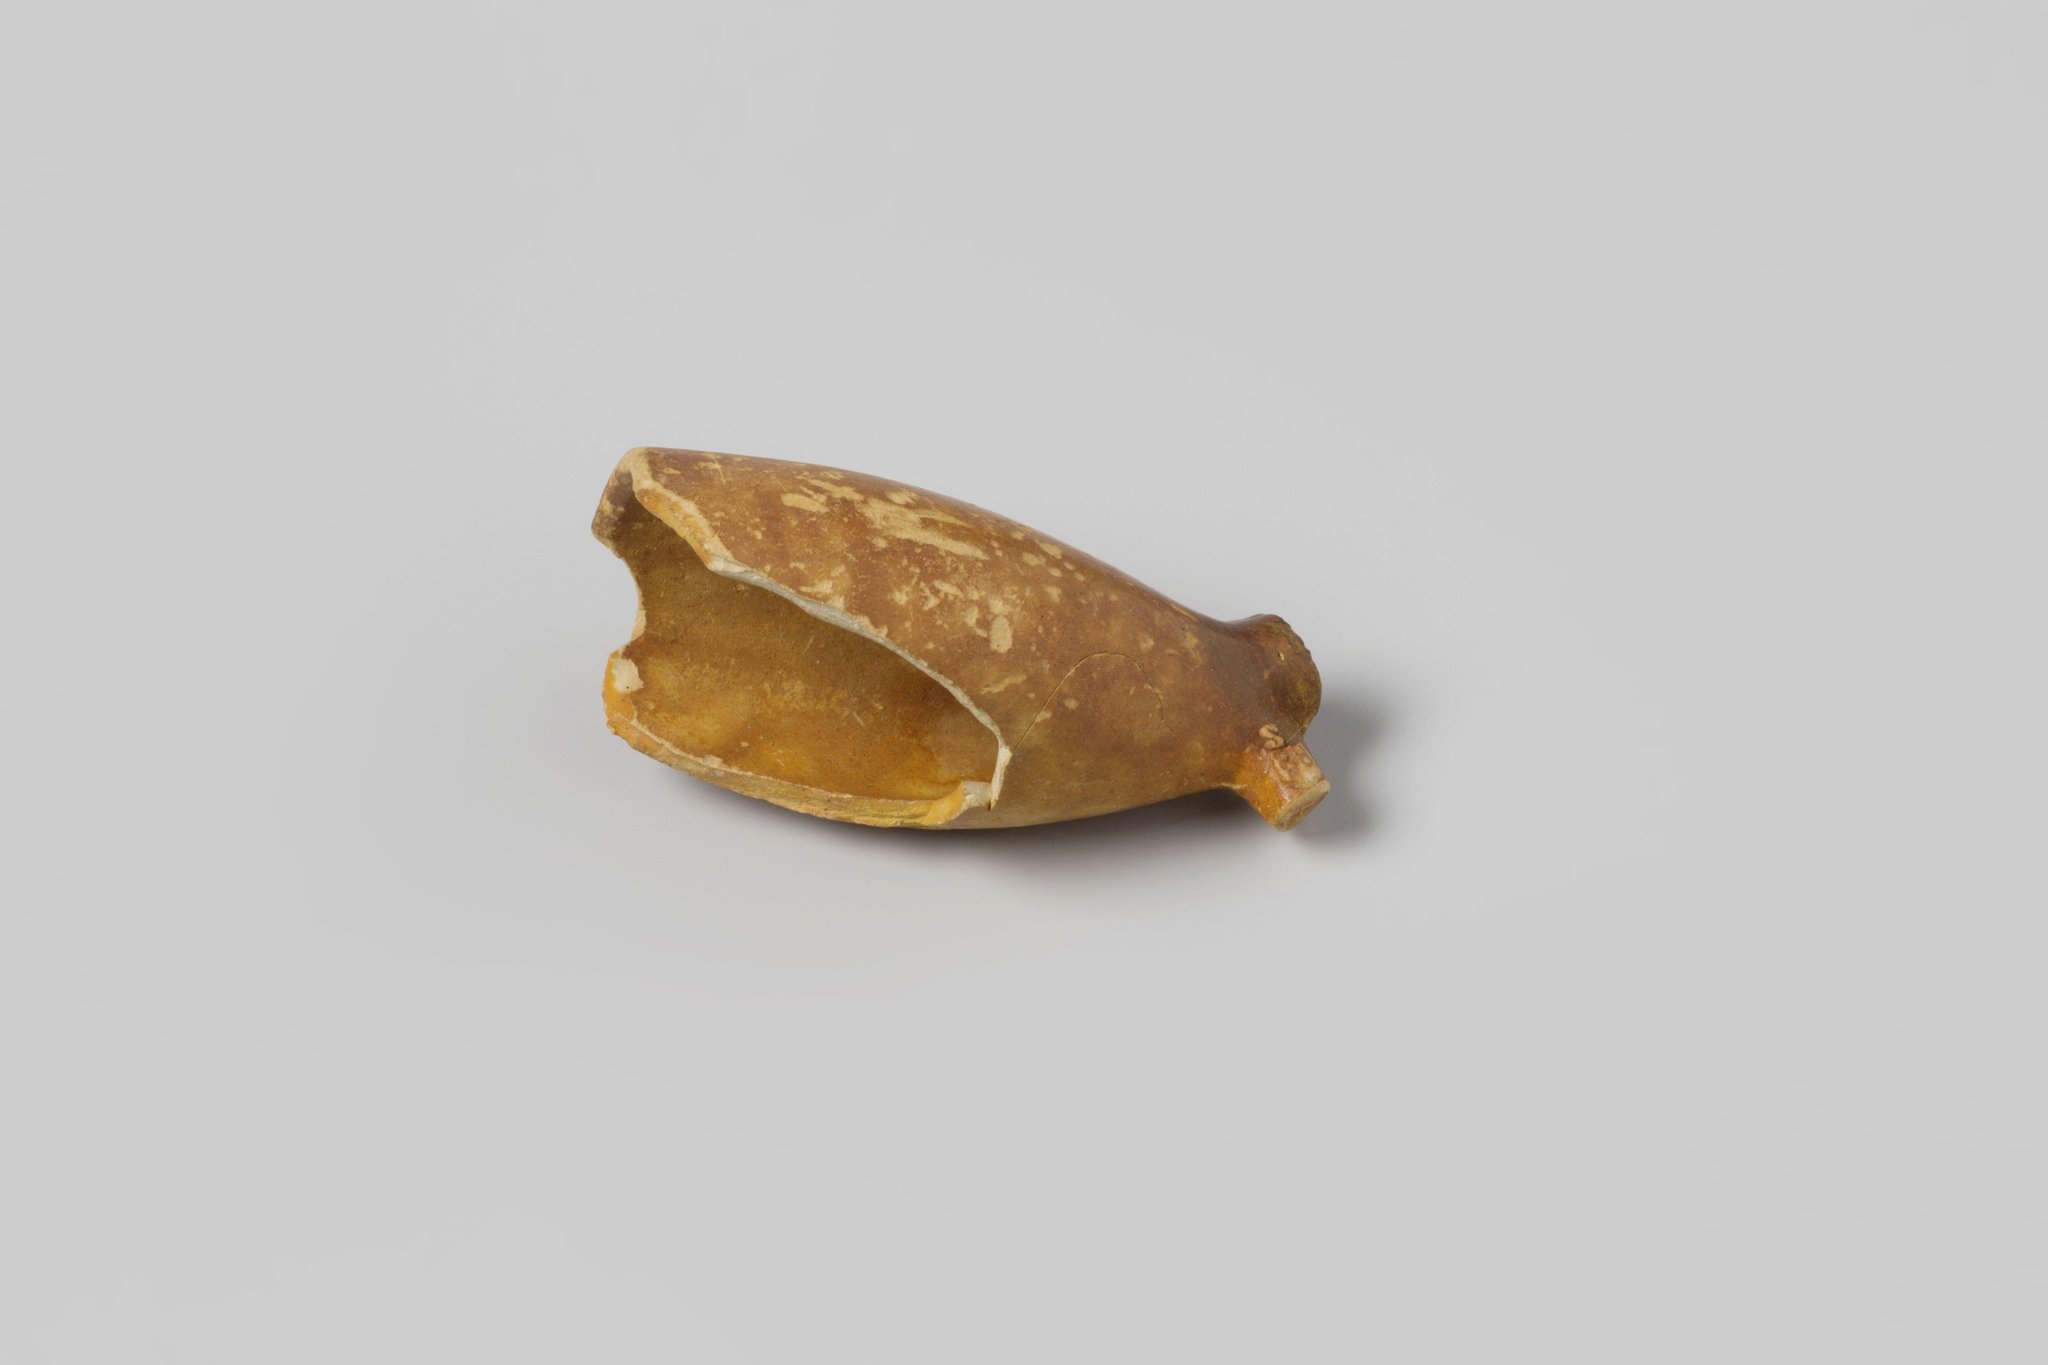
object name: pipe bowl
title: Fragment pijpenkop uit het wrak van de Oost-Indiëvaarder Hollandia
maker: Anonymous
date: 1700-1743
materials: clay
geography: netherlands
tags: verenigde oostindische compagnie, hollandia (schip), annet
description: Pipe, bowl, heelmark: tobacco's brazier; 1hsm3.